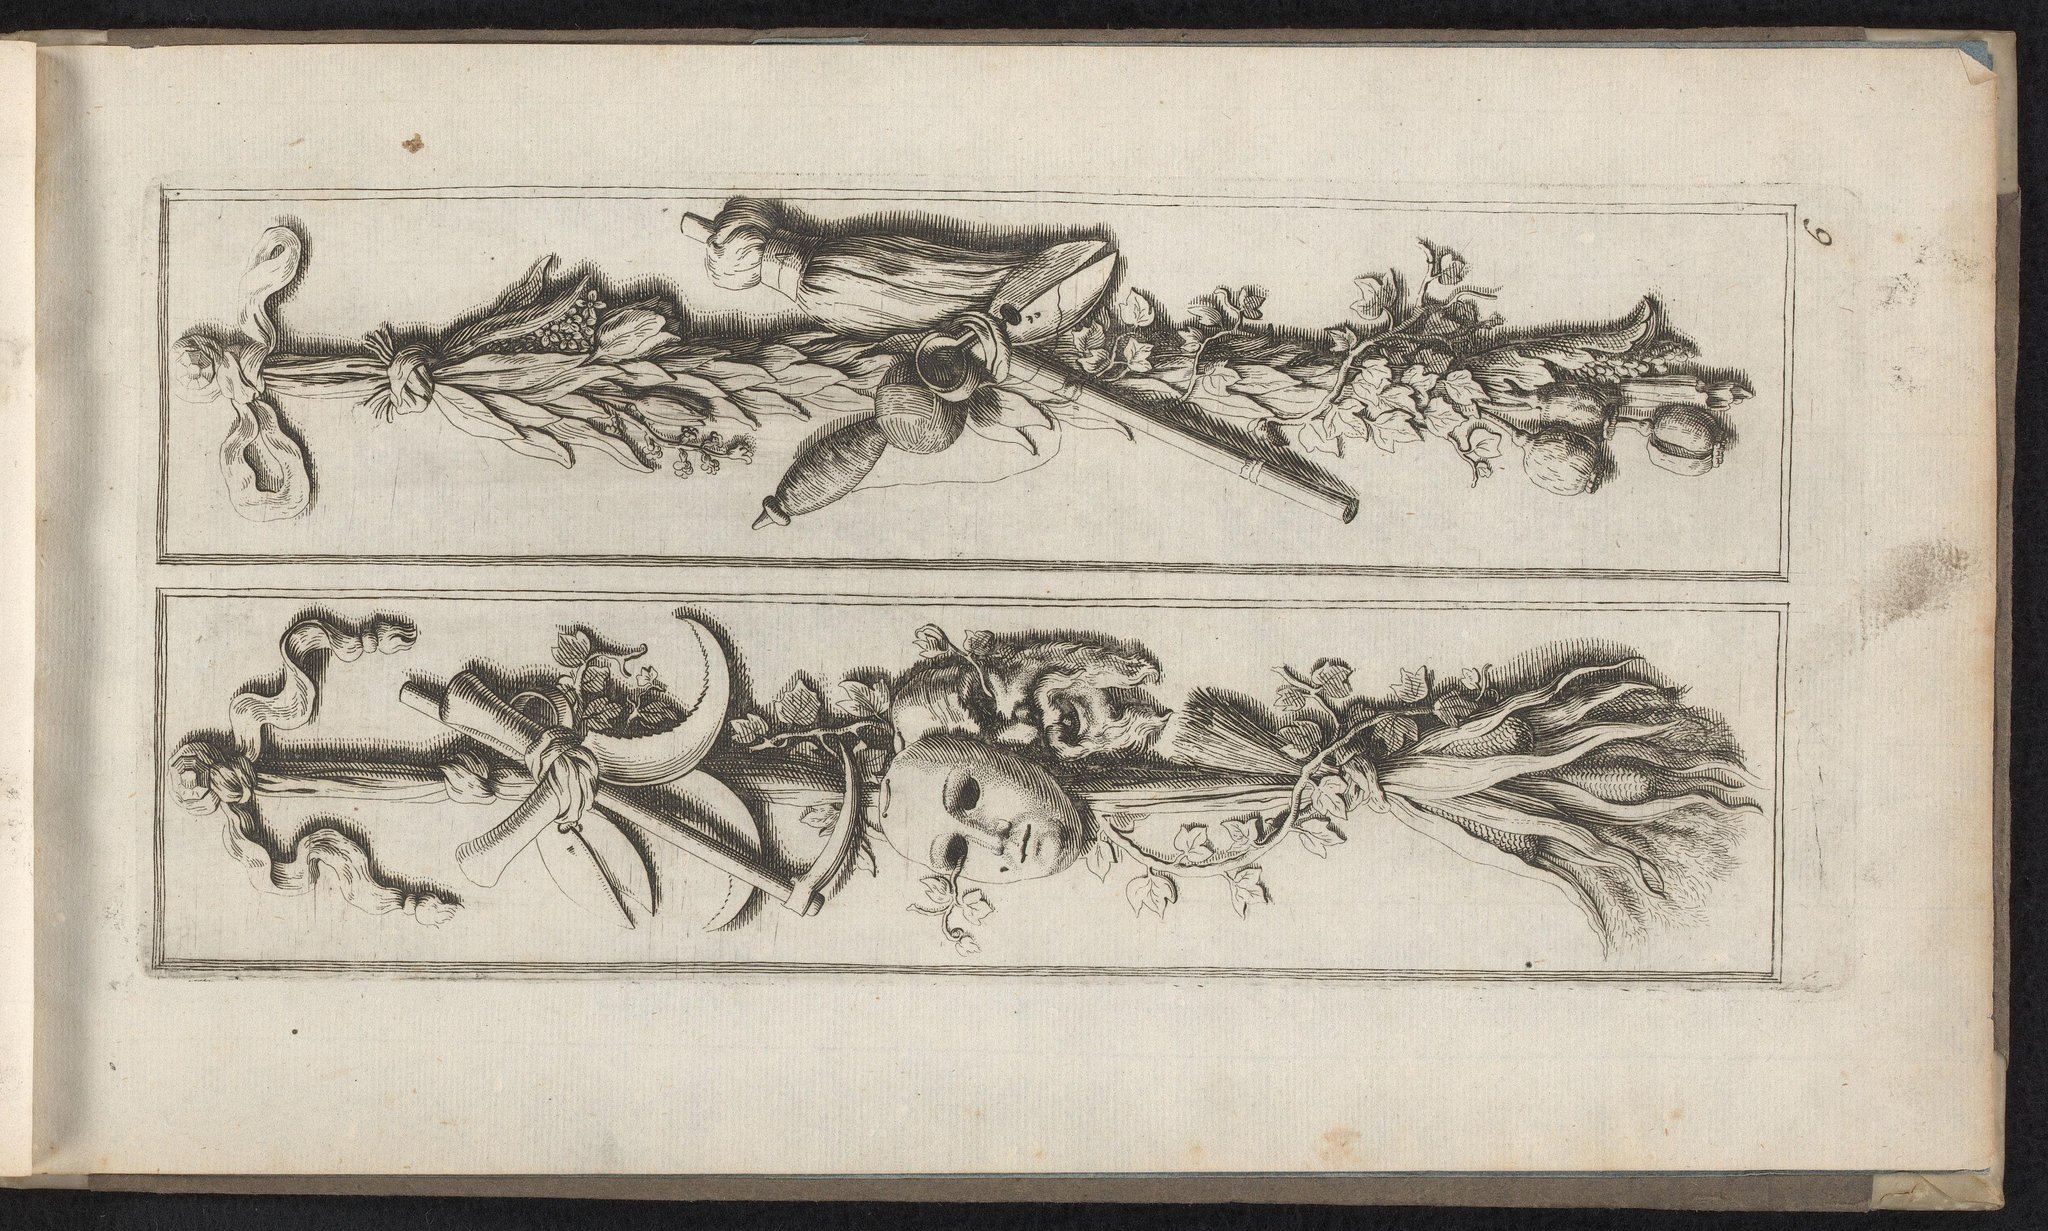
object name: ornament print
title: Pilasterfestoenen met theatermaskers uit het stadhuis van Amsterdam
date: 1665-1685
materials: ink, paper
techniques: etching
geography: amsterdam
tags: mask, ornament ~ festoon, garland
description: Een prent van vijf genummerde prenten met festoenen met titelpagina. Kopieën in spiegelbeeld naar de prenten in Artus Quellinus, Prima Pars Praecipuarium(…), Amsterdam 1665. Gebonden in 19de-eeuwse band met blauwe kaft en witte rug, genummerd: 3.